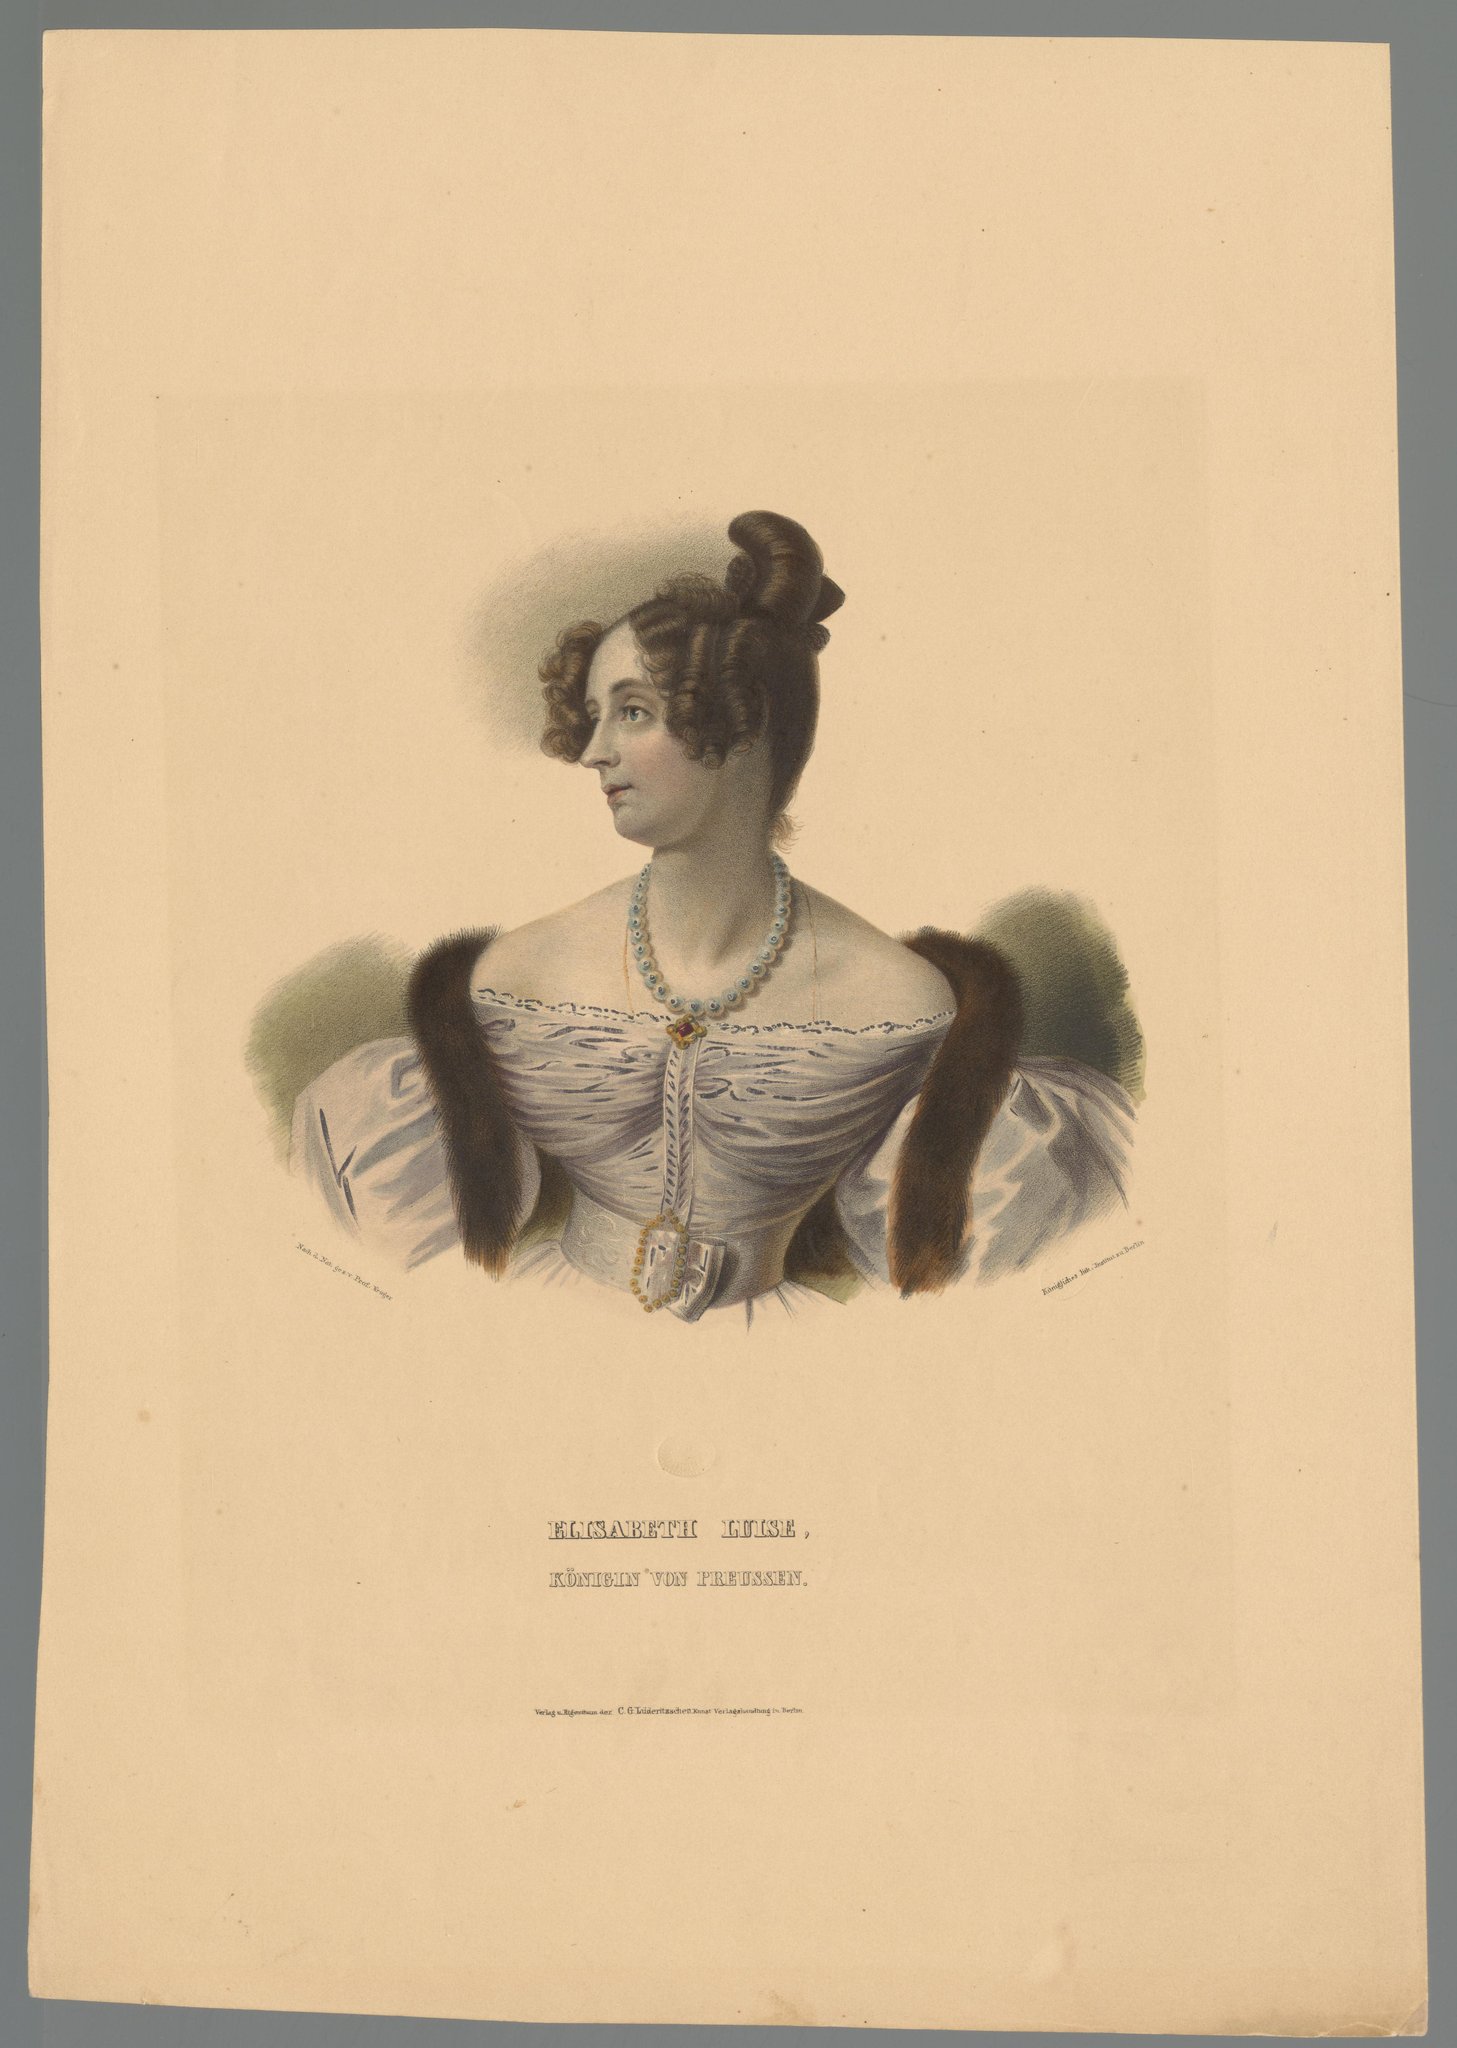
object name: print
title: Elisabeth van Beieren, koningin van Pruisen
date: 1840-1850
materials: paper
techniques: lithograph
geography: berlin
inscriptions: check stamp: Lugt 4519